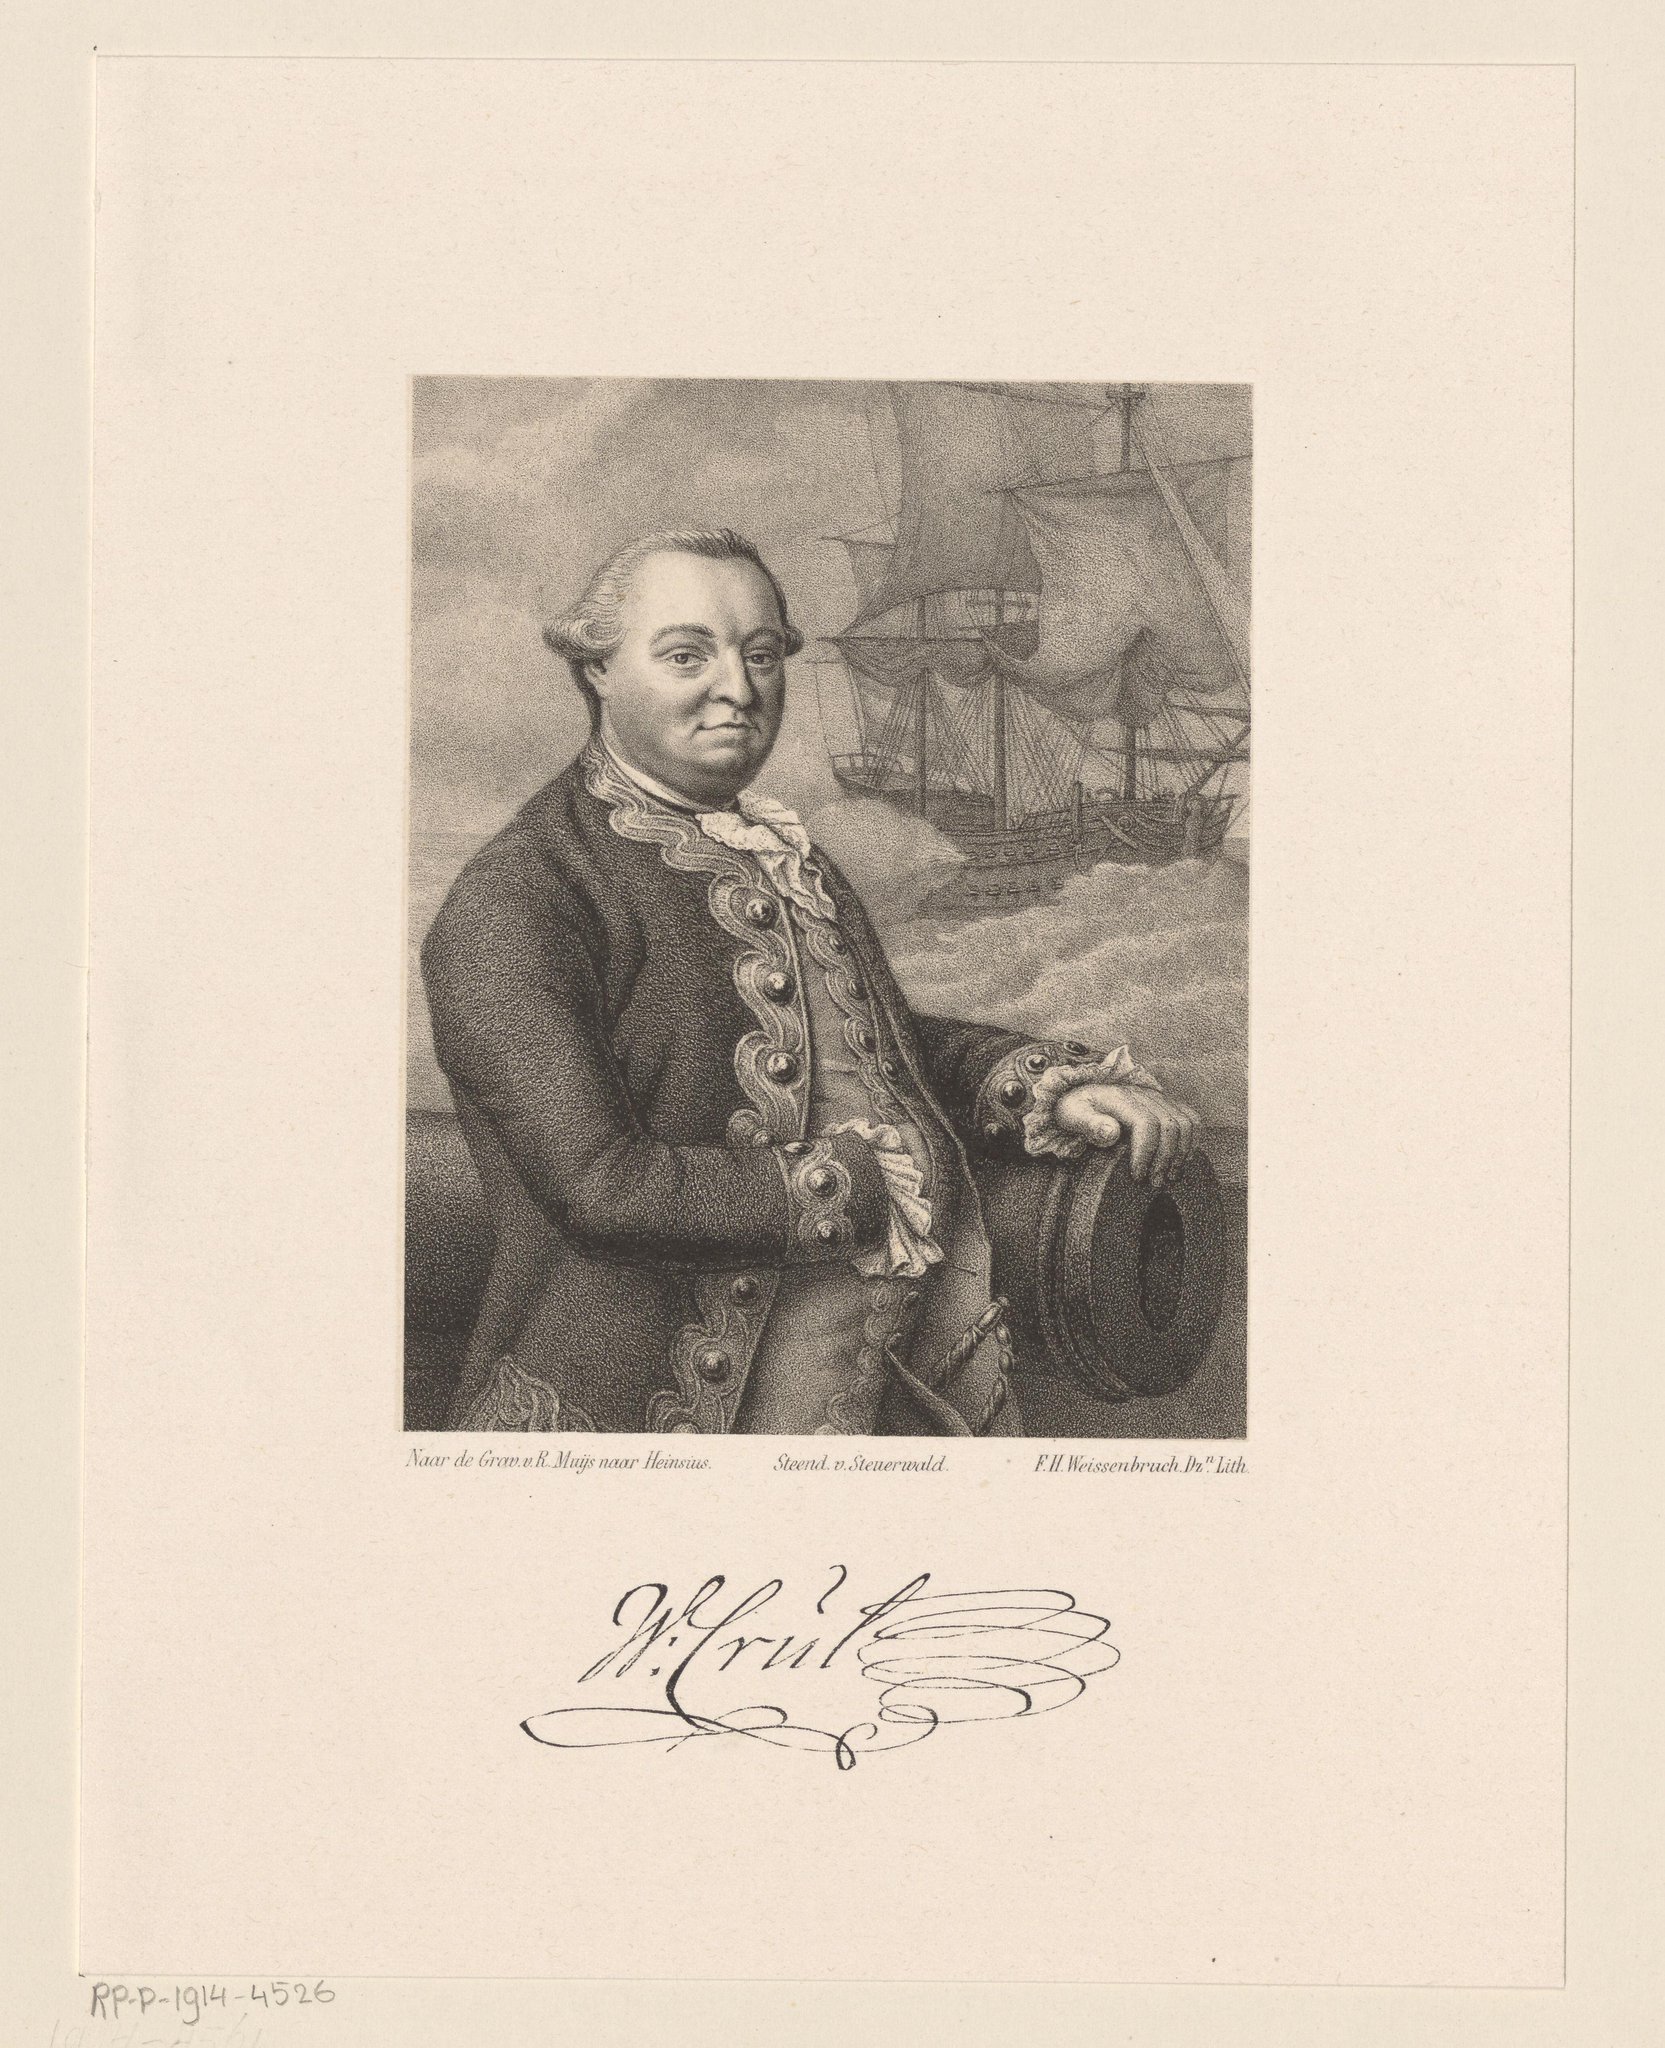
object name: print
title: Portret van Willem Crul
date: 1822-1863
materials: paper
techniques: lithograph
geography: the hague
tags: haarlem, historical persons, ships (in general), firearms: cannon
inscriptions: collector's mark: Lugt 2228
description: Willem Crul bij een kanon met een zeilschip op de achtergrond. Onder het portret een facsimile van de handtekening van de geportretteerde.